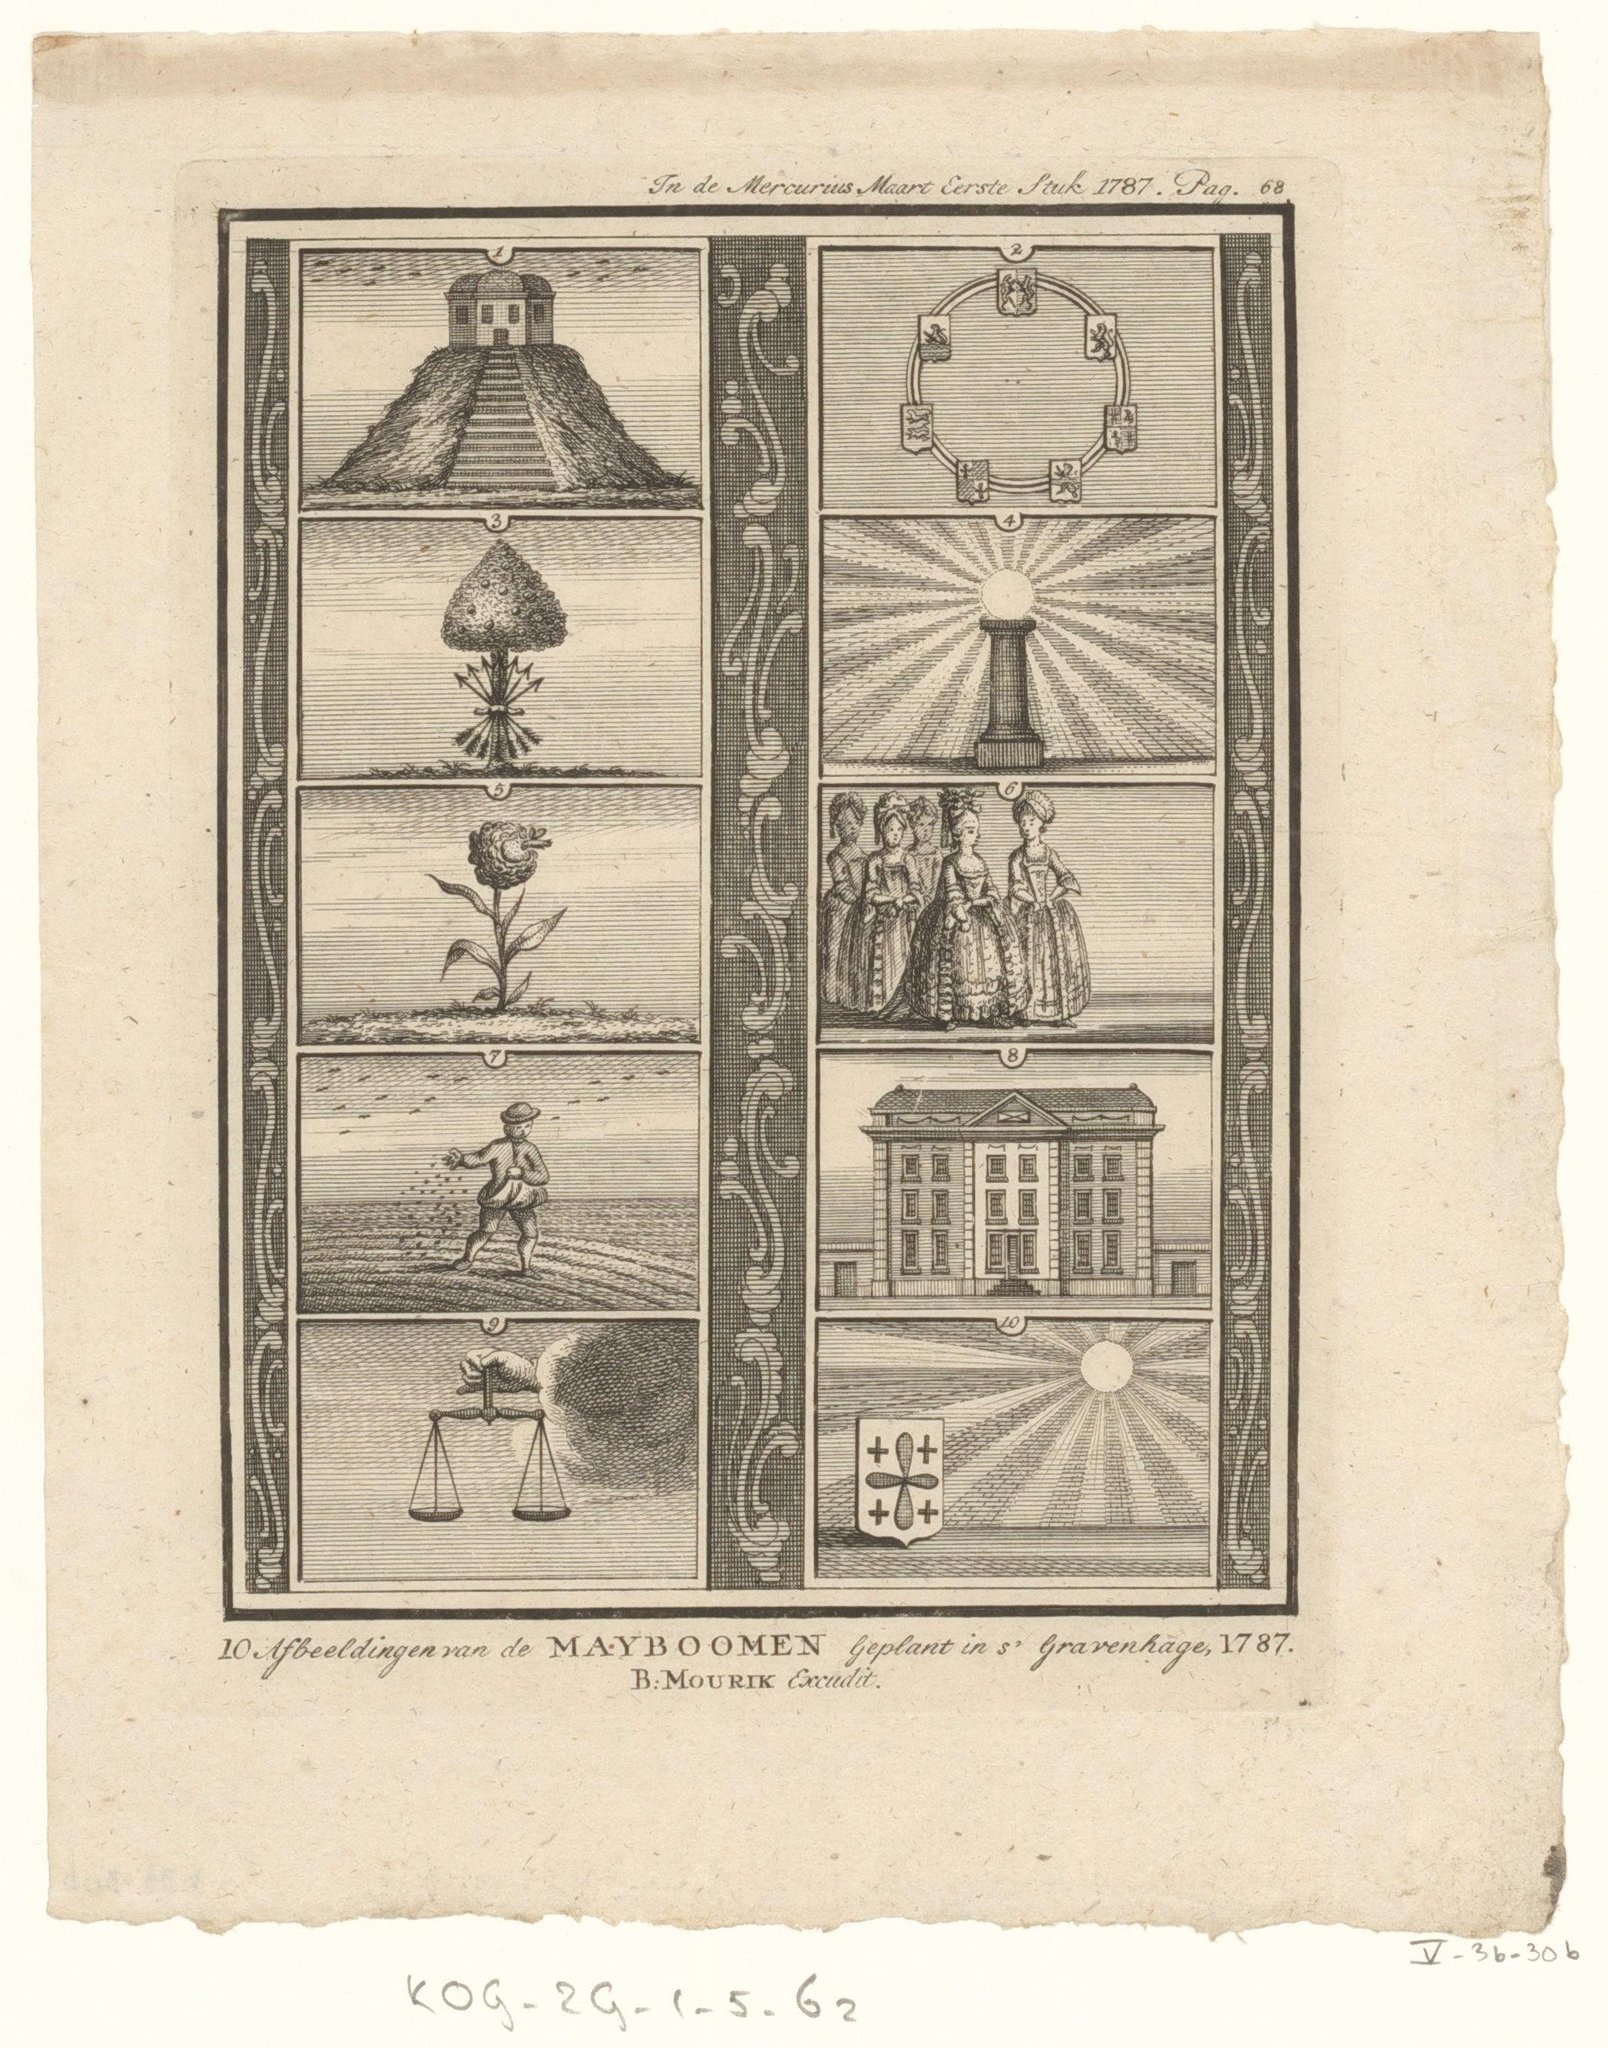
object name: book illustration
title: 10 Afbeeldingen van de May-boomen Geplant in 's Gravenhage 1787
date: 1703-1787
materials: paper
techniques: engraving, etching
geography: amsterdam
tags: maypole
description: Tien genummerde afbeeldingen in twee rijen van vijf. Rechtsboven genummerd: In de Mercurius Maart Eerste Stuk 1787. Pag. 68 Onderwerpsrubrieken binnen de Atlas Zeden en Gewoonten: Krijgswezen, Schutterij, Meiboomen.